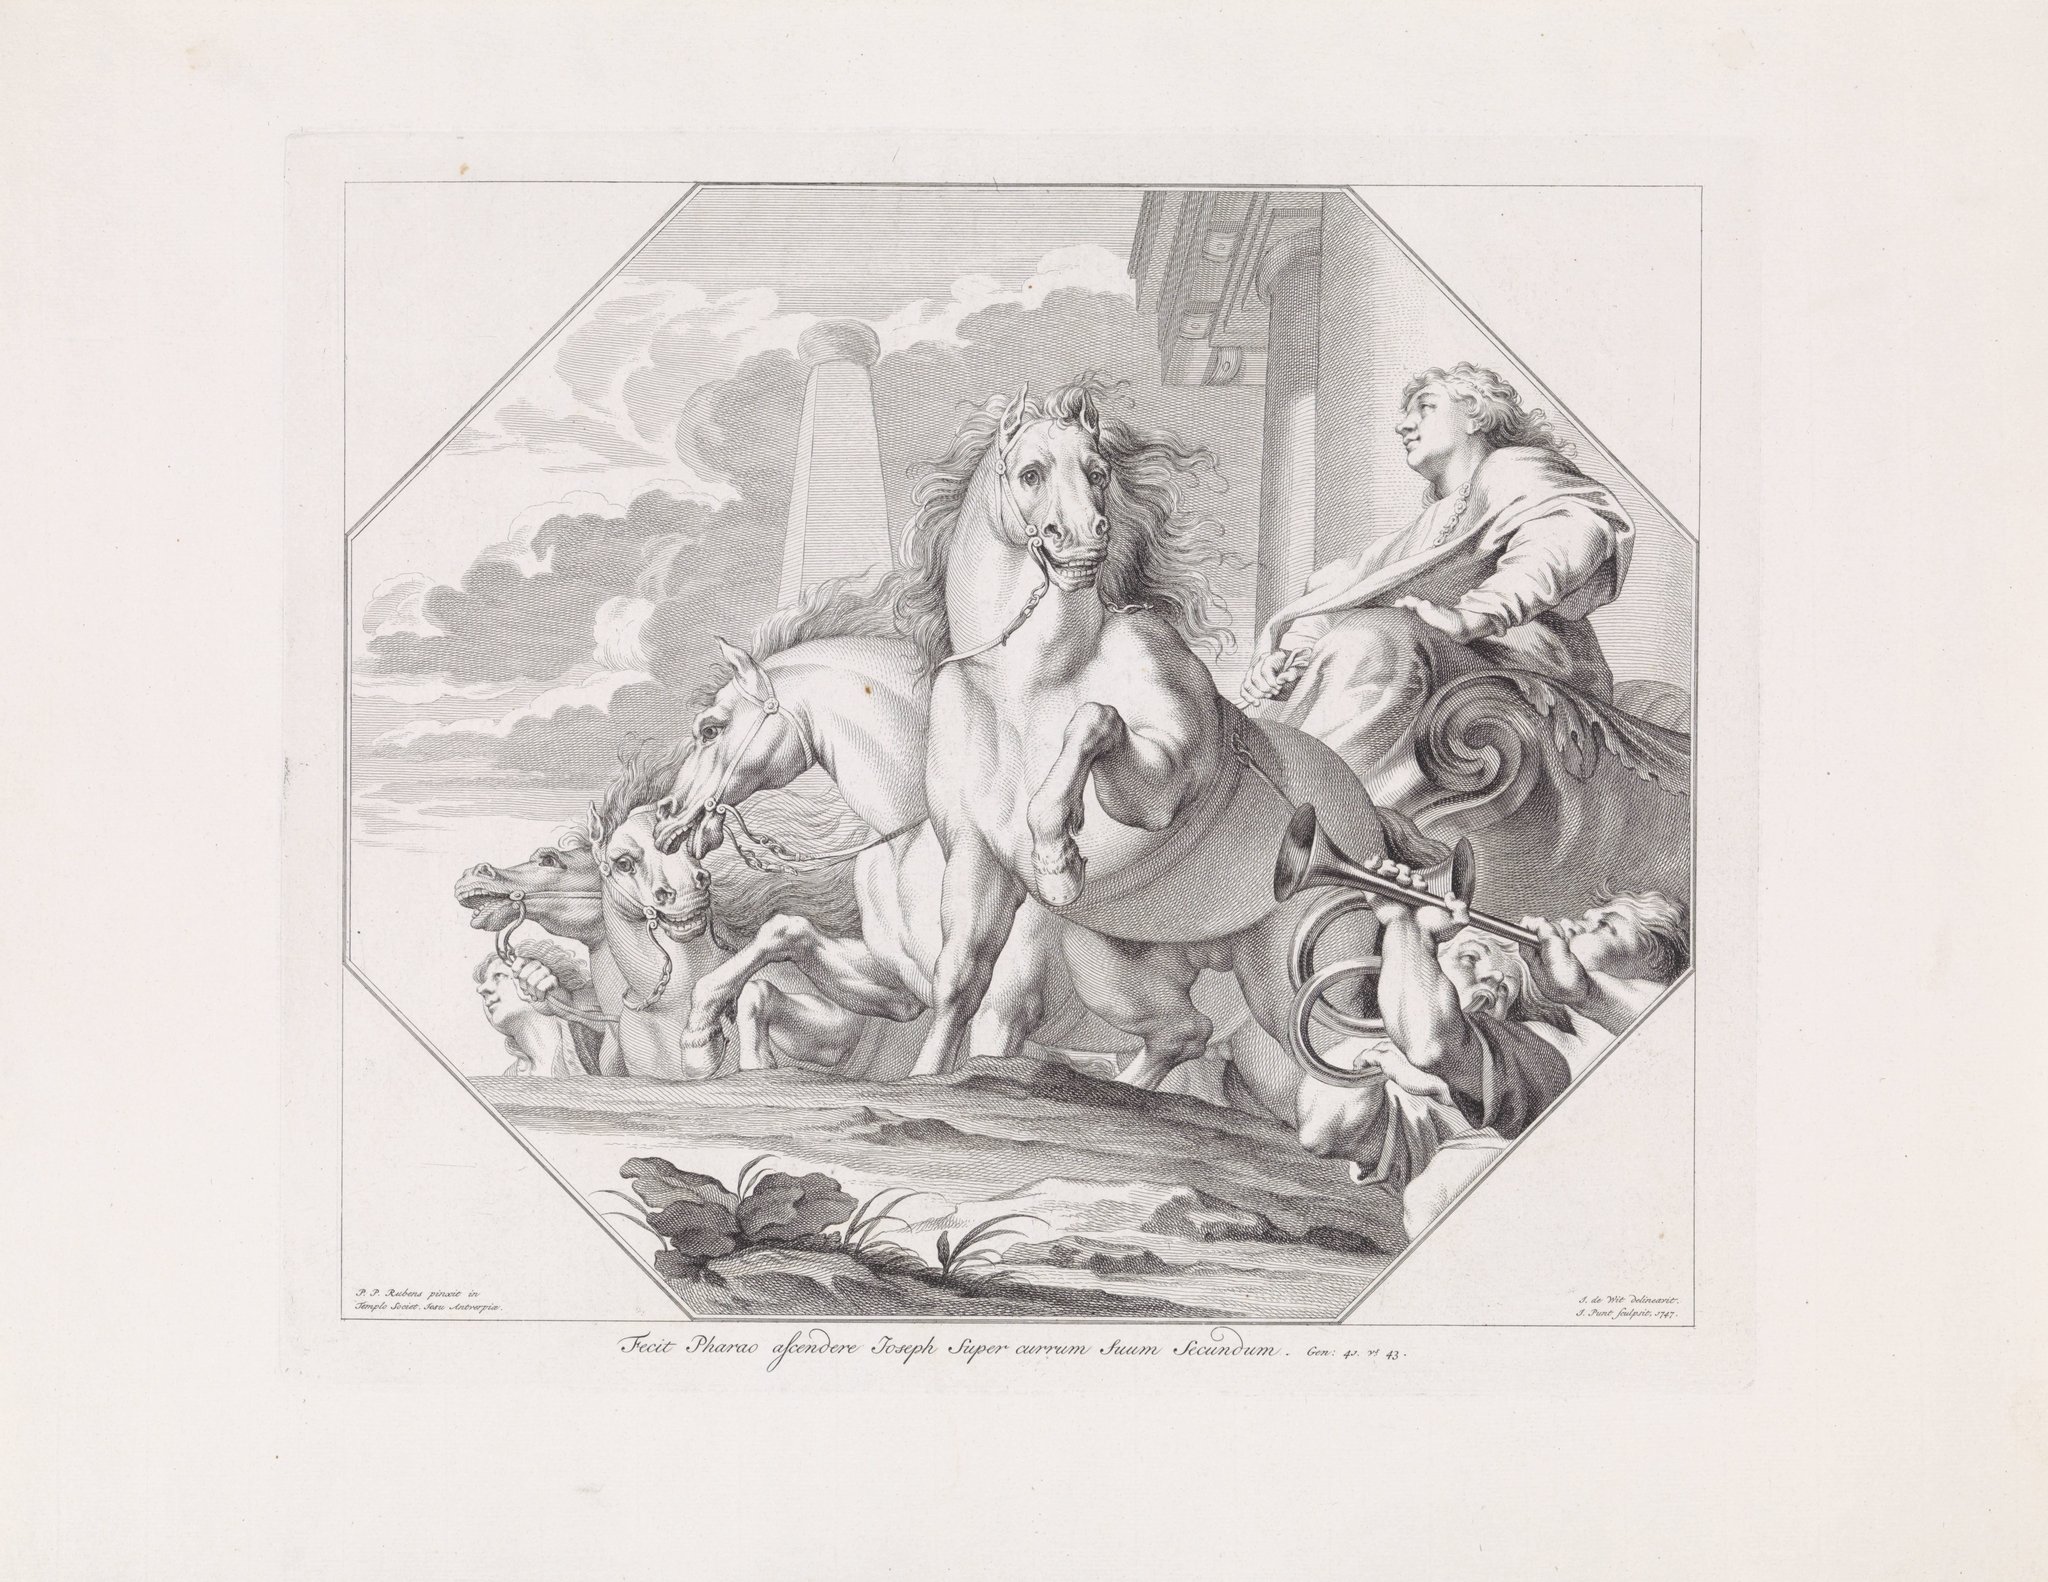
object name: print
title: Les plat-fonds ou les tableaux des galeries / De plafonds of gallerystukken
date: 1747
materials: paper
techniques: engraving, etching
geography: amsterdam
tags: triumph of joseph: dressed in a royal attire he rides in one of pharaoh's chariots, preceded by a herald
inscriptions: collector's mark: Lugt 240, date: ‘1747’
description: In koninklijk gewaad zetelt Jozef in een wagen van Farao. Onder de octagonale voorstelling een vers in het Latijn uit Gen. 41:43.